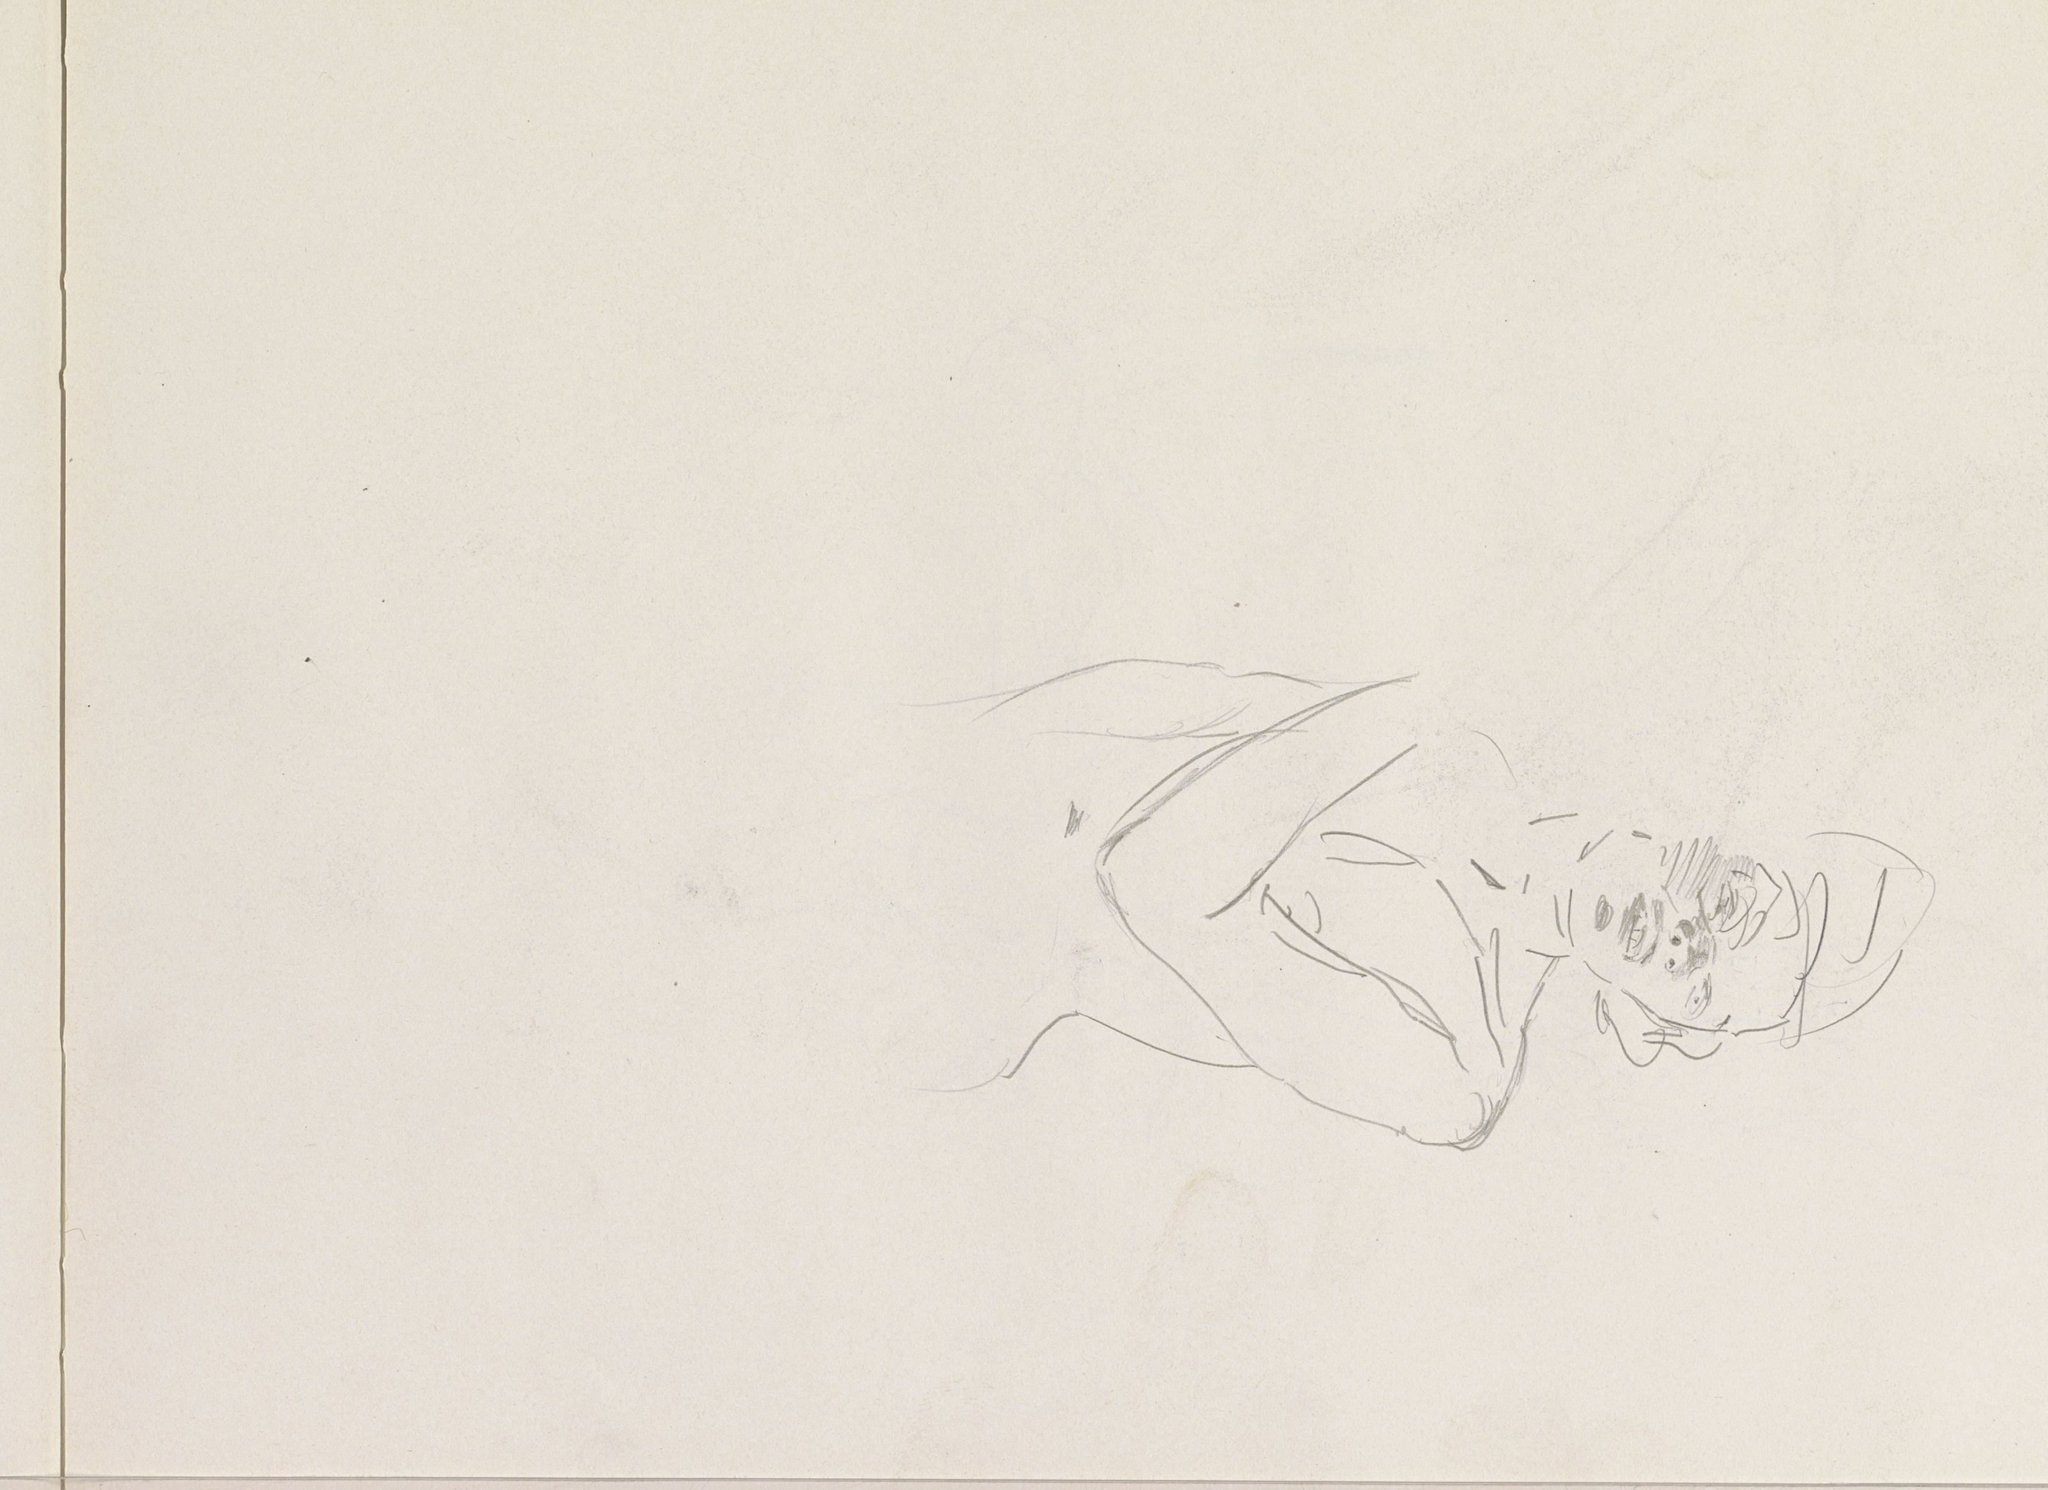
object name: sketchbook leaf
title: Vrouwelijk naakt, mogelijk liggend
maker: isaac israels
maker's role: draughtsman, painter, print maker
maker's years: 1865-1934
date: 1915-1934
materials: paper, pencil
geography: the hague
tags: the (nude) human figure; 'corpo humano' (ripa) - aa - female human figure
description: Blad 21 recto uit schetsboek III met 36 bladen.